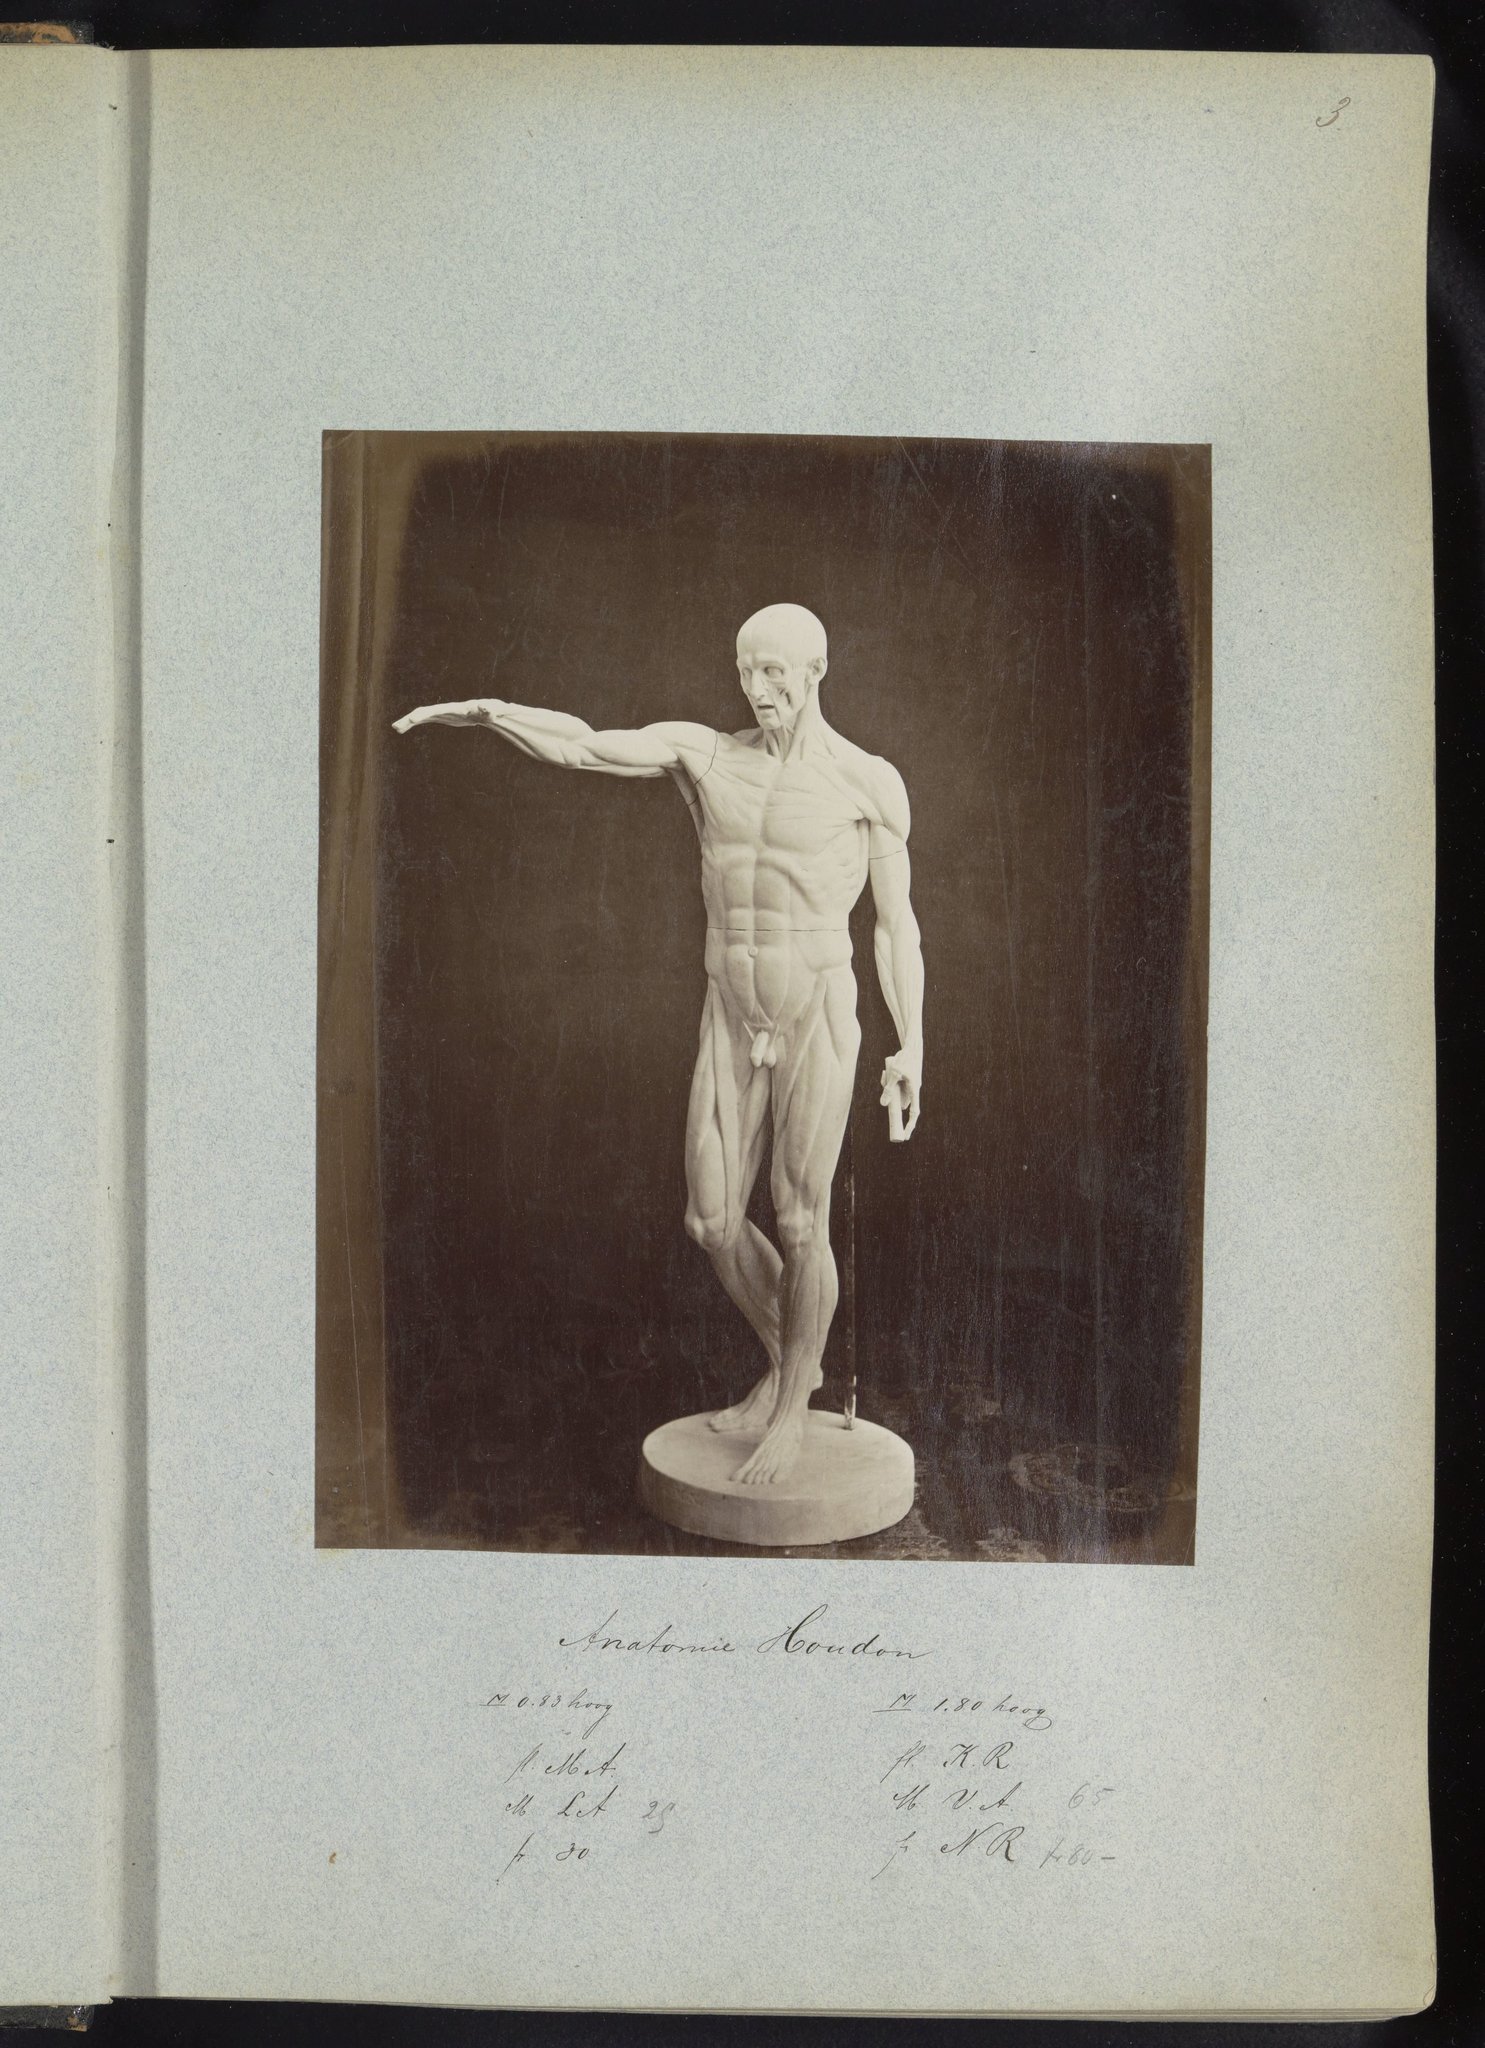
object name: photograph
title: Gipsen afgietsel van een sculptuur naar studie van Houdon over de anatomie van het menselijk lichaam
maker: Anonymous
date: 1875-1900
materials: paper, photographic support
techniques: albumen print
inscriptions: annotation, annotation: ‘Anatomie Houdon’, annotation: ‘M 0.83 hoog M 1.80 hoog’